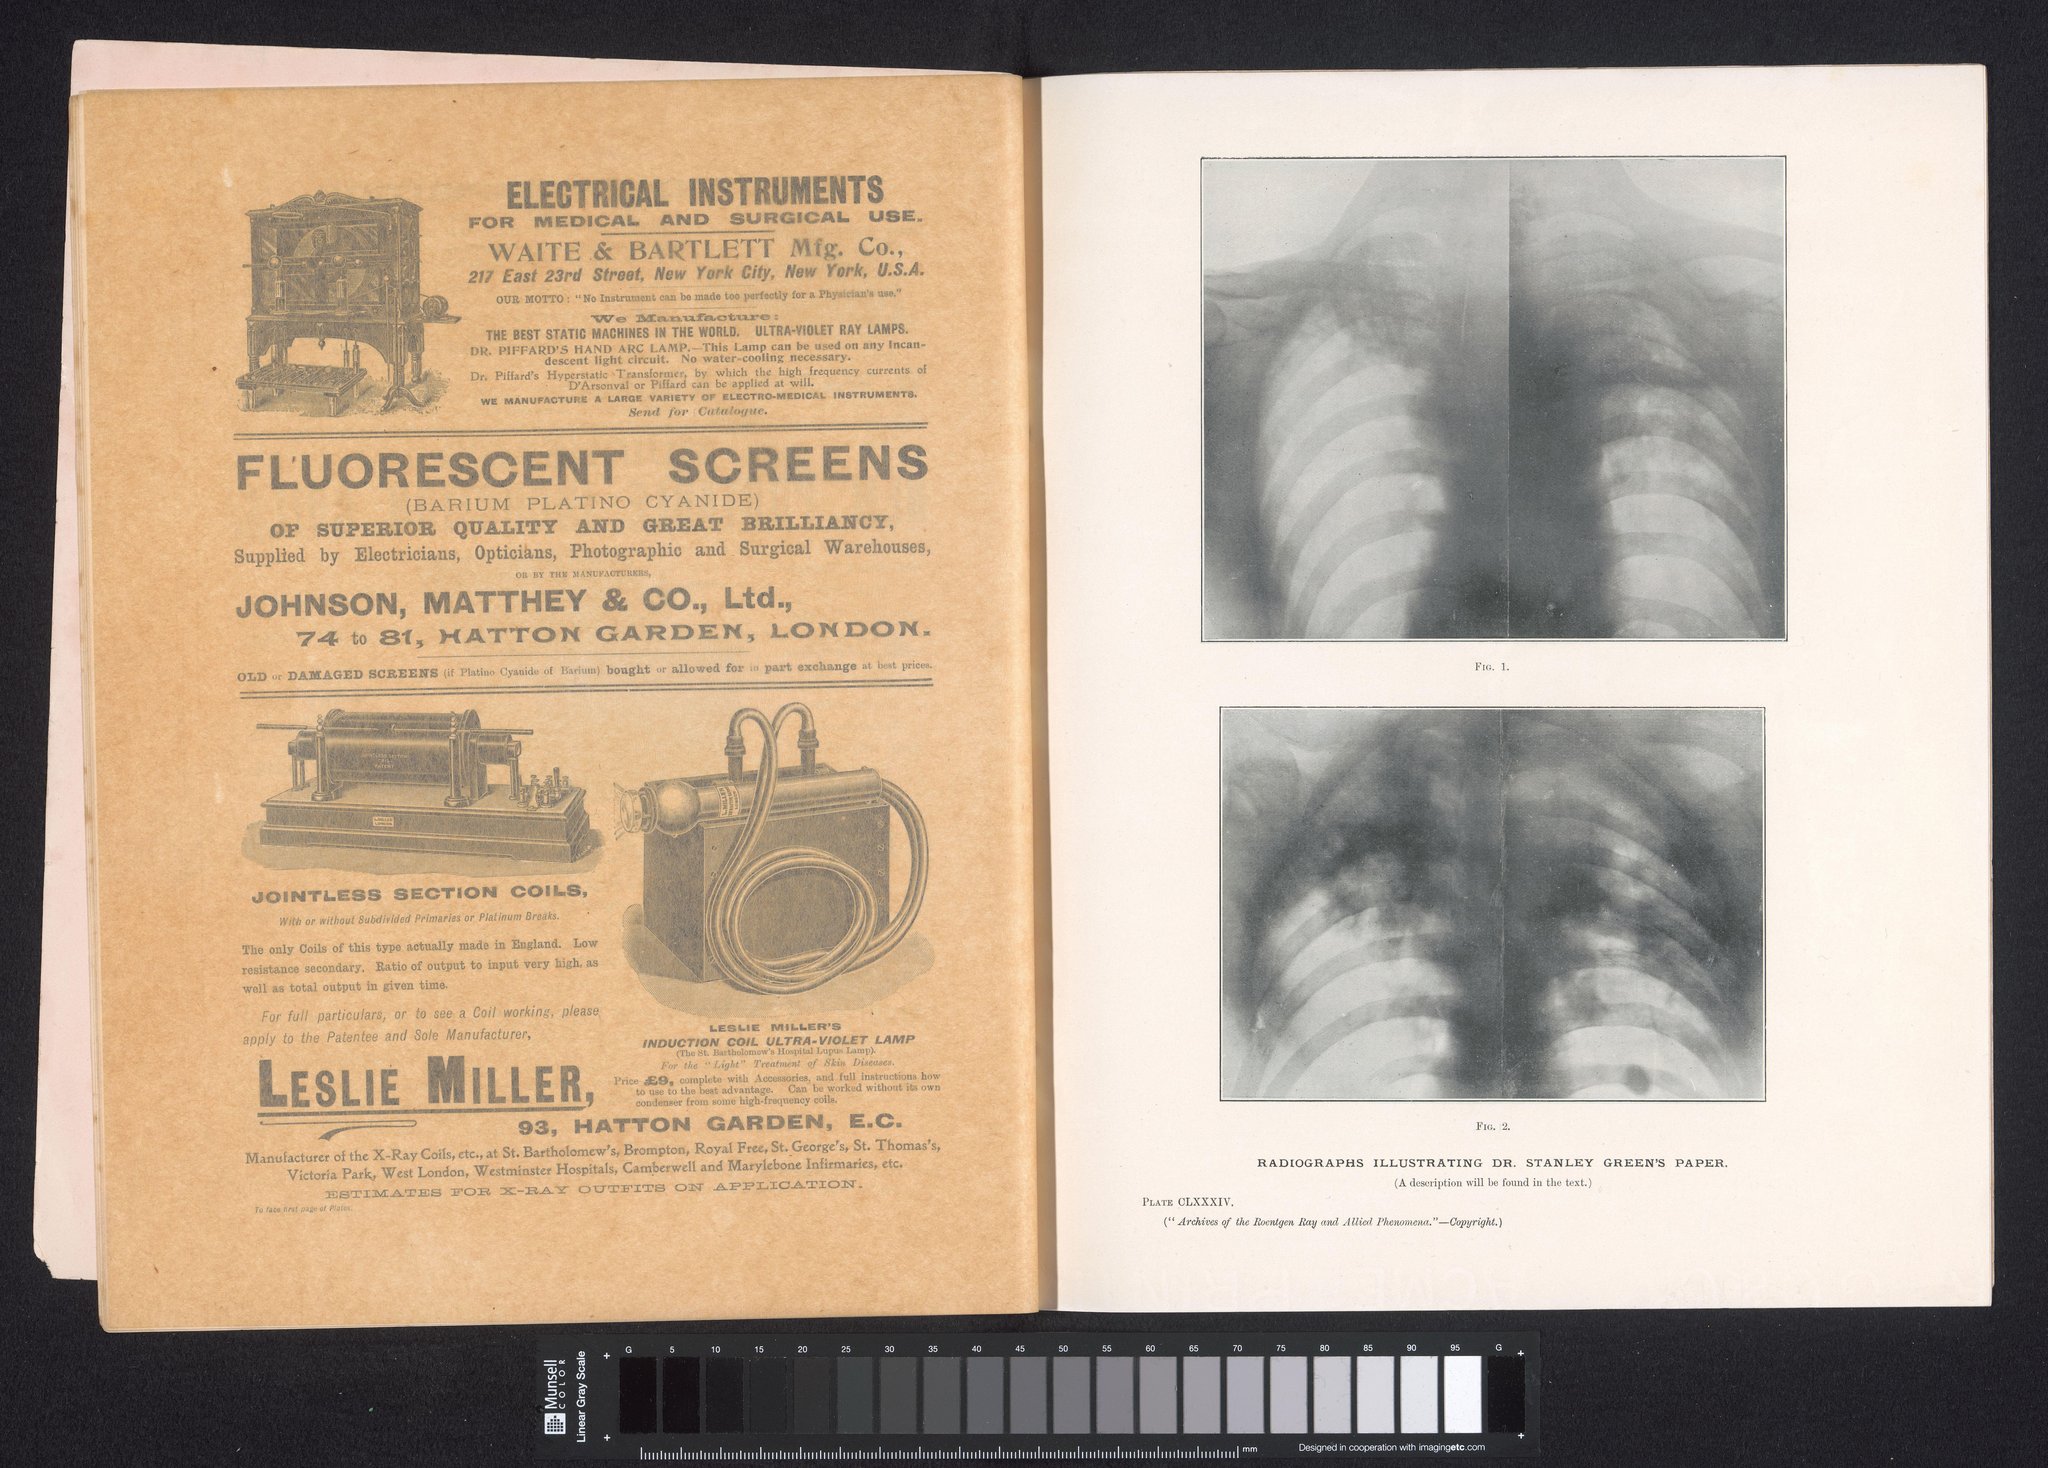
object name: photomechanical print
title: Radiographs illustrating dr. Stanley Green's paper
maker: Anonymous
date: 1894-1904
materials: paper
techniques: autotype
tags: chest, bust, x-ray examination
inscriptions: number: ‘Fig. 1. Fig. 2. Plate CLXXXIV. (“Archives of the Roentgen Ray and Allied Phenomena.”-Copyright.)’